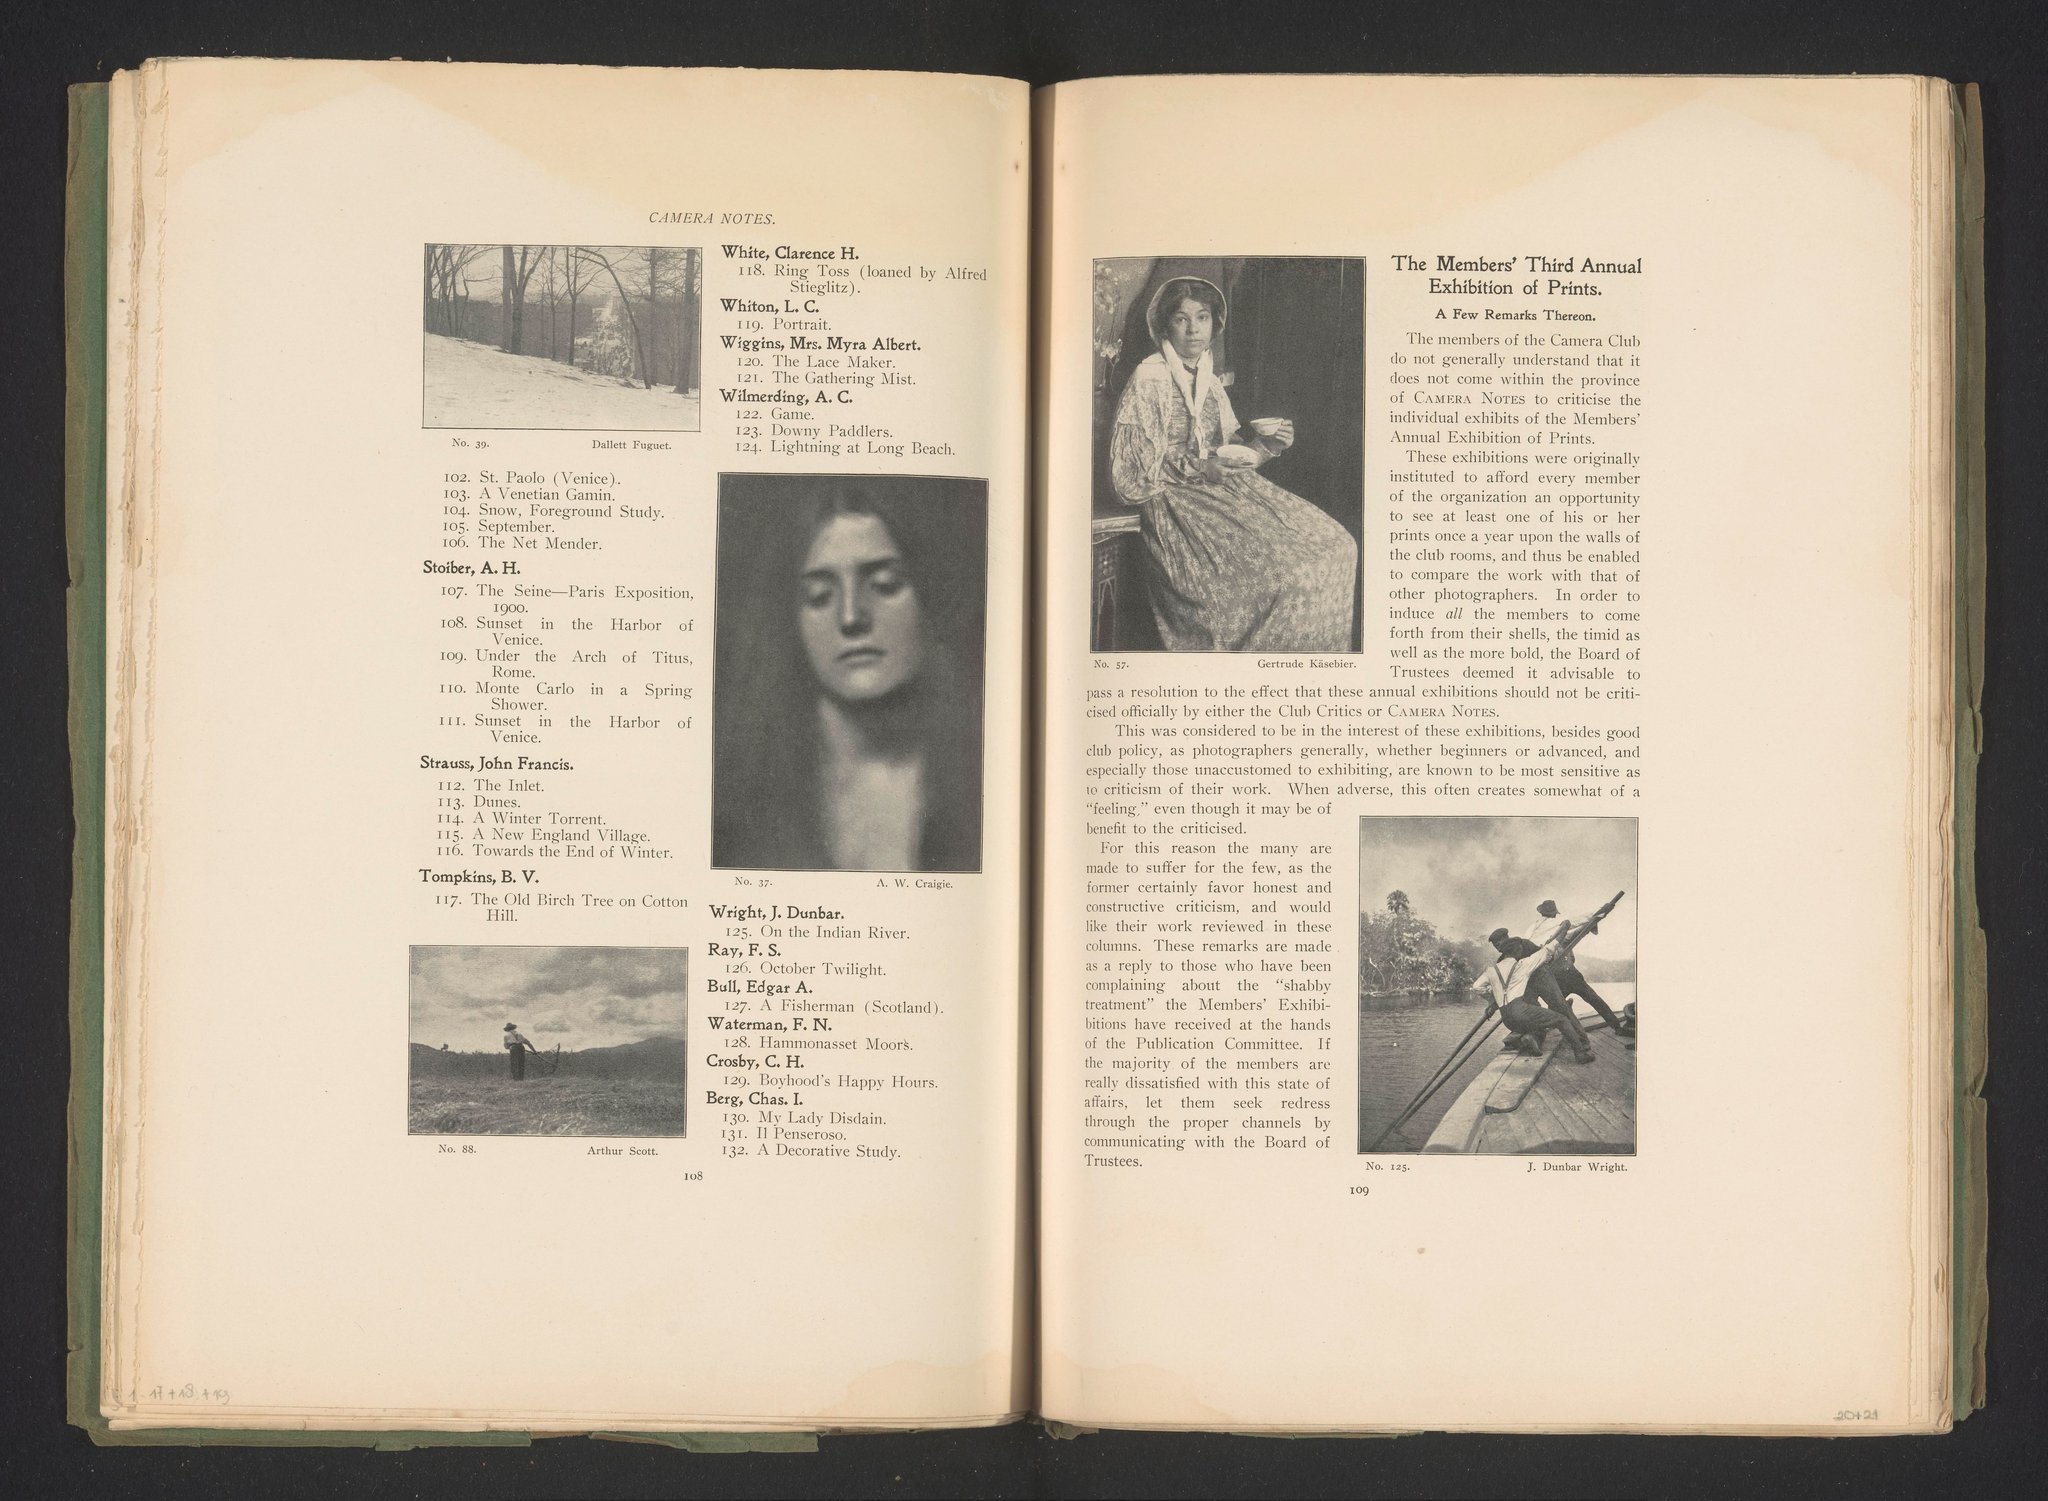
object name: photomechanical print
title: Portret van een onbekende vrouw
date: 1895-1900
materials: paper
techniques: autotype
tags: historical persons not known by name - bb - woman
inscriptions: number: ‘No. 37’